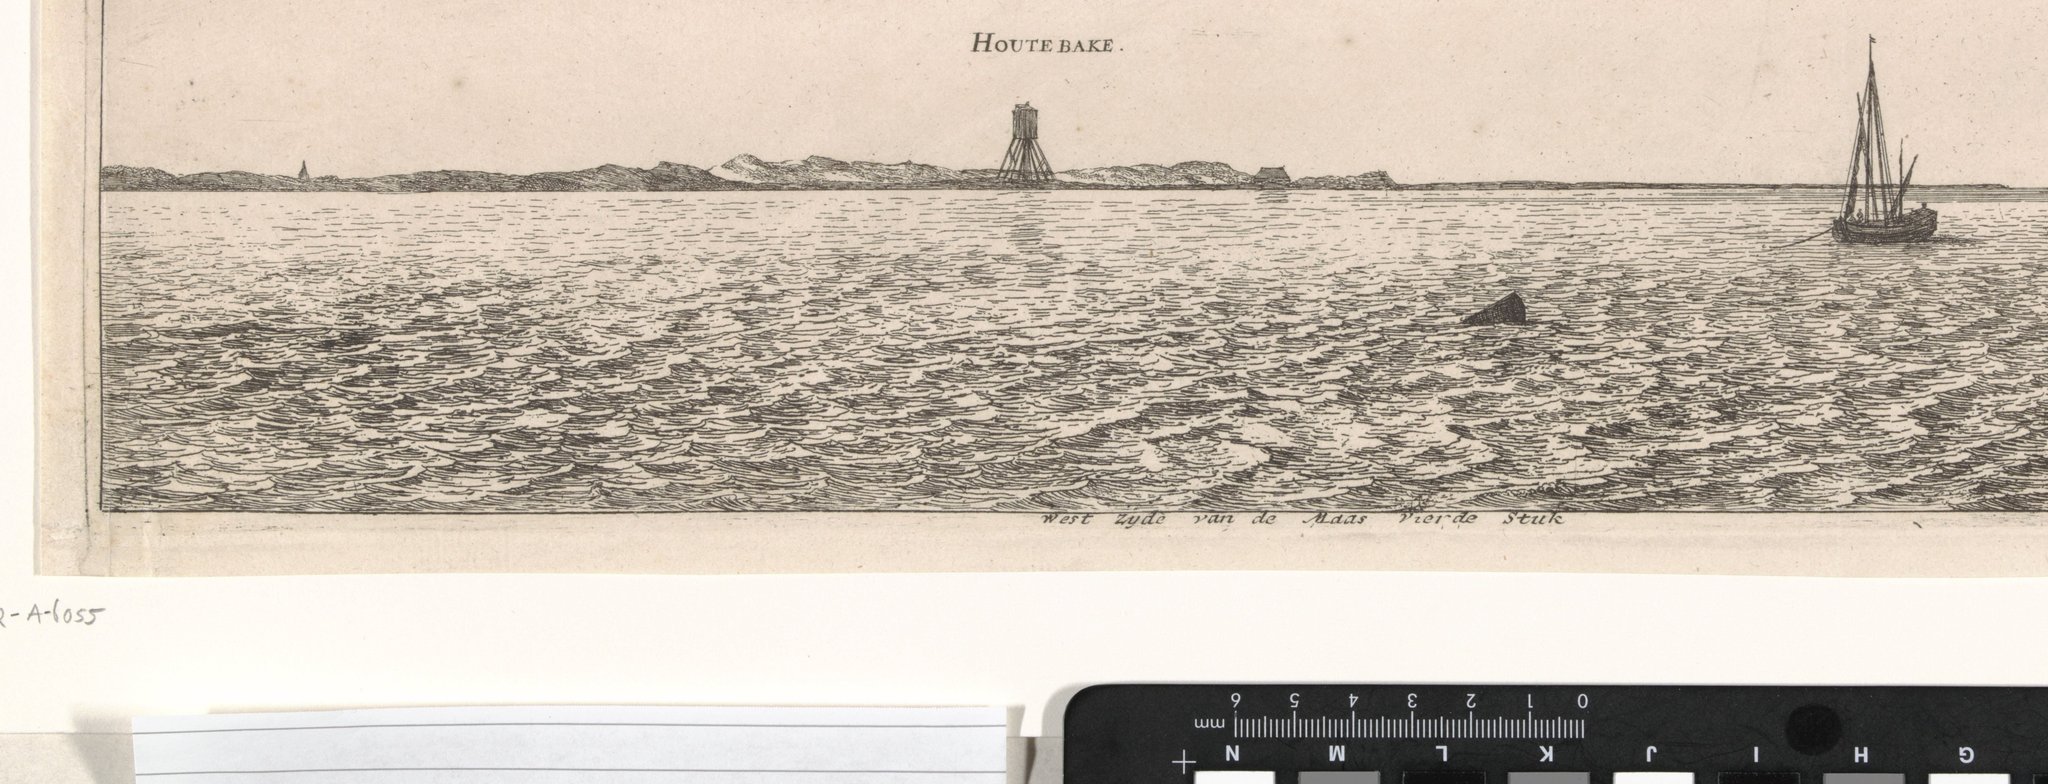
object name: print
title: Gezicht op een vuurbaken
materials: paper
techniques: engraving, etching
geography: rotterdam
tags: river, beacon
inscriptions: collector's mark: Lugt 2228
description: Gezicht op de westzijde van de Maas met op de achtergrond een houten vuurbaken.